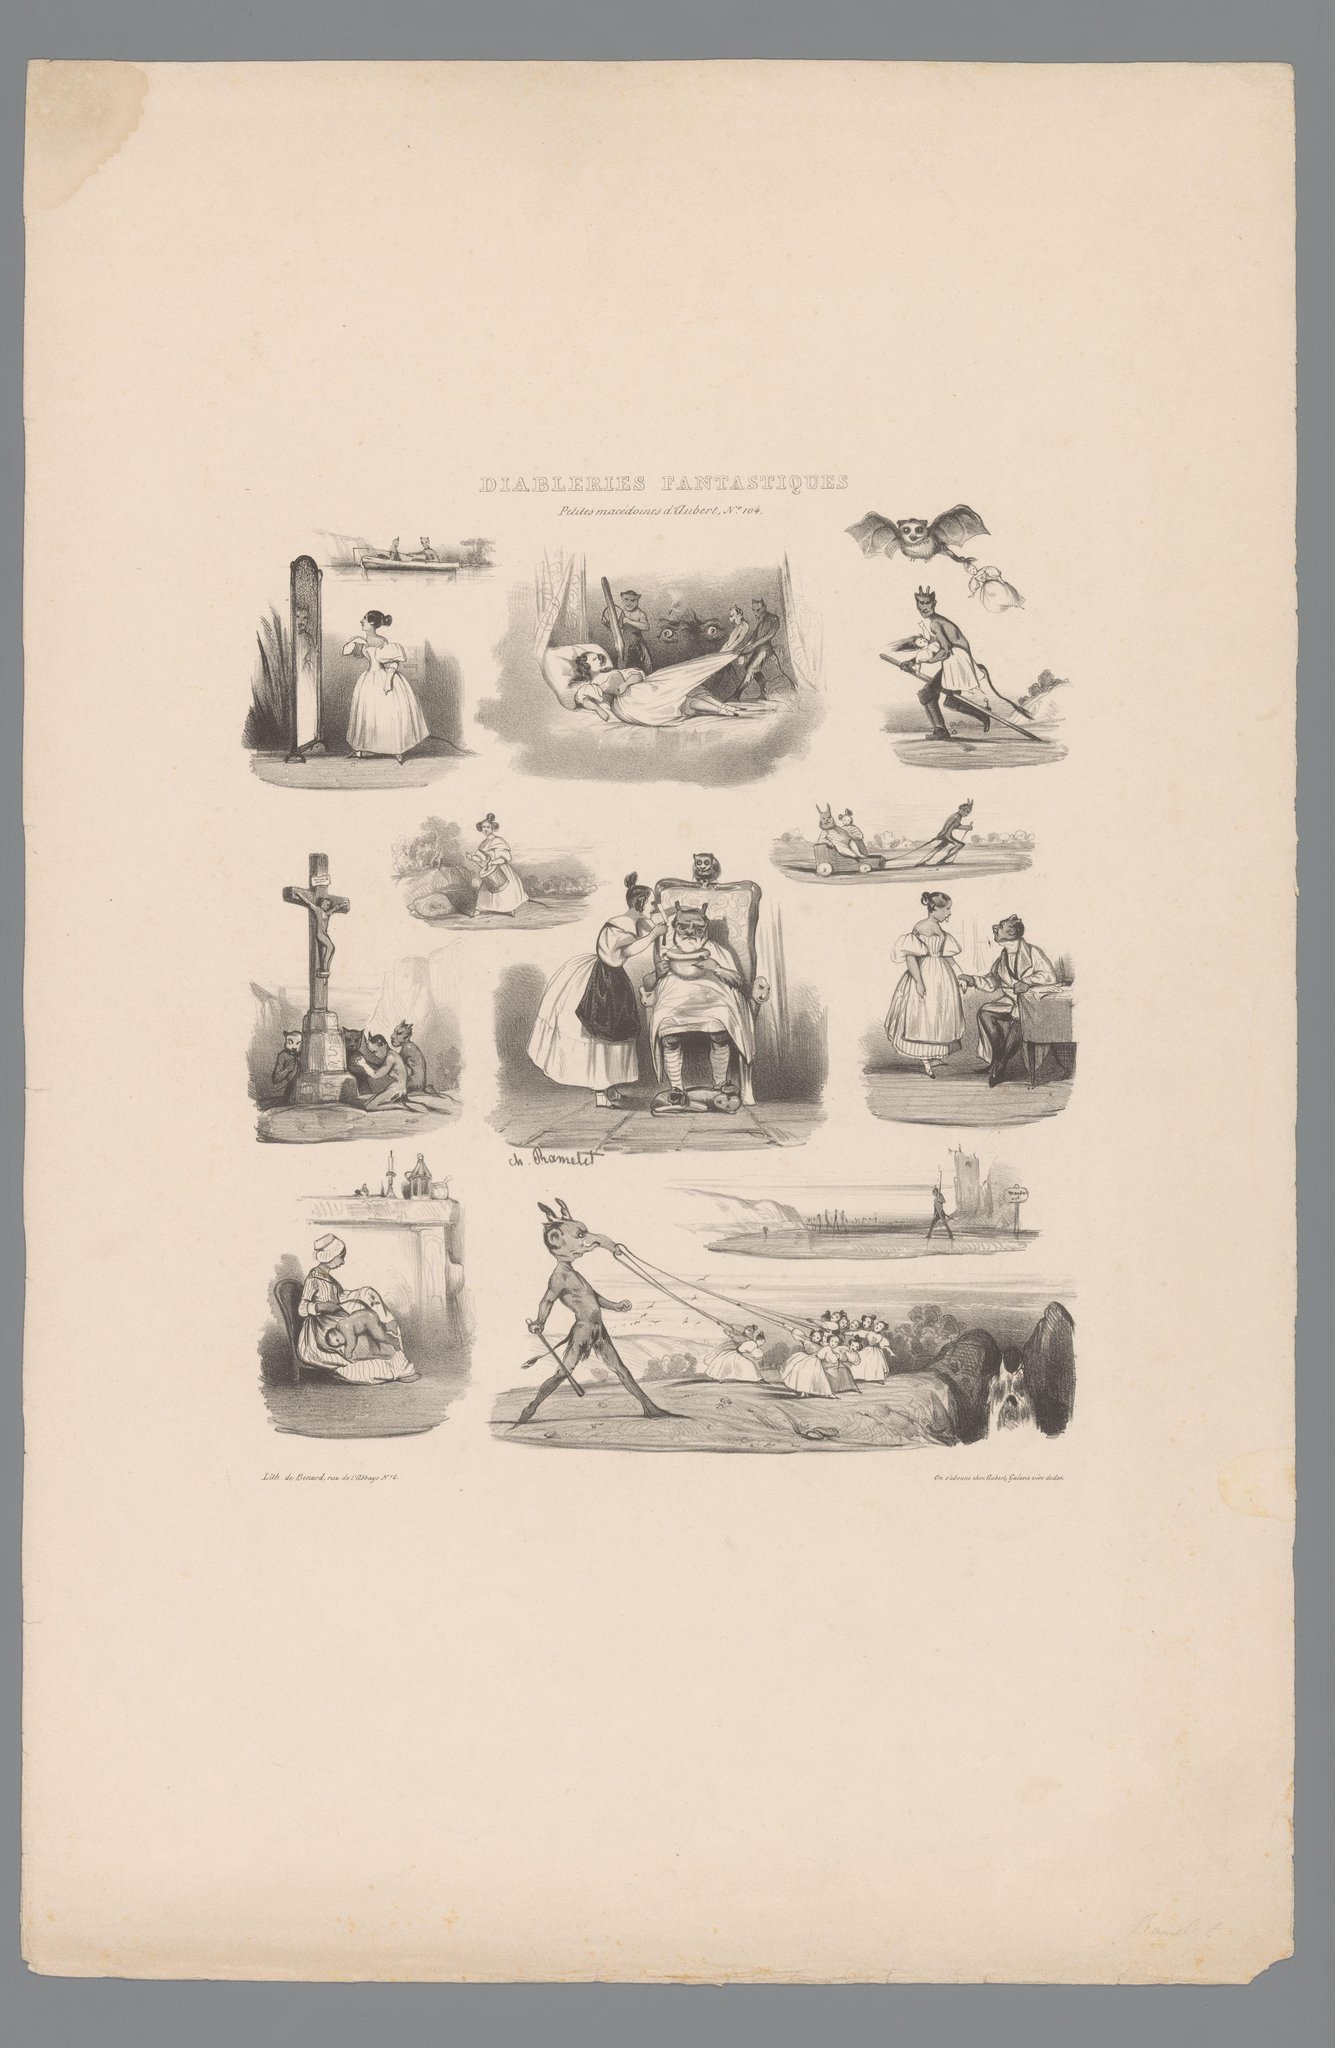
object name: cartoon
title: Kleine en gevarieerde taferelen van Aubert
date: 1833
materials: paper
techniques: lithograph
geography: paris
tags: activities of devil(s)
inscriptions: collector's mark: Lugt 2228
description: Eerdere staat van prent gebruikt in: Le Charivari 2 (1833), nr. 112, 22 maart 1833. De serie "Petites macédoines d'Aubert" bestaat uit ten minste 256 prenten.